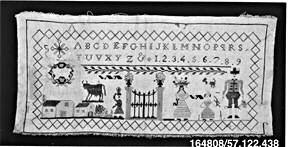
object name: sampler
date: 1801-1900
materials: canvas, cotton, wool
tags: animals,gates,men